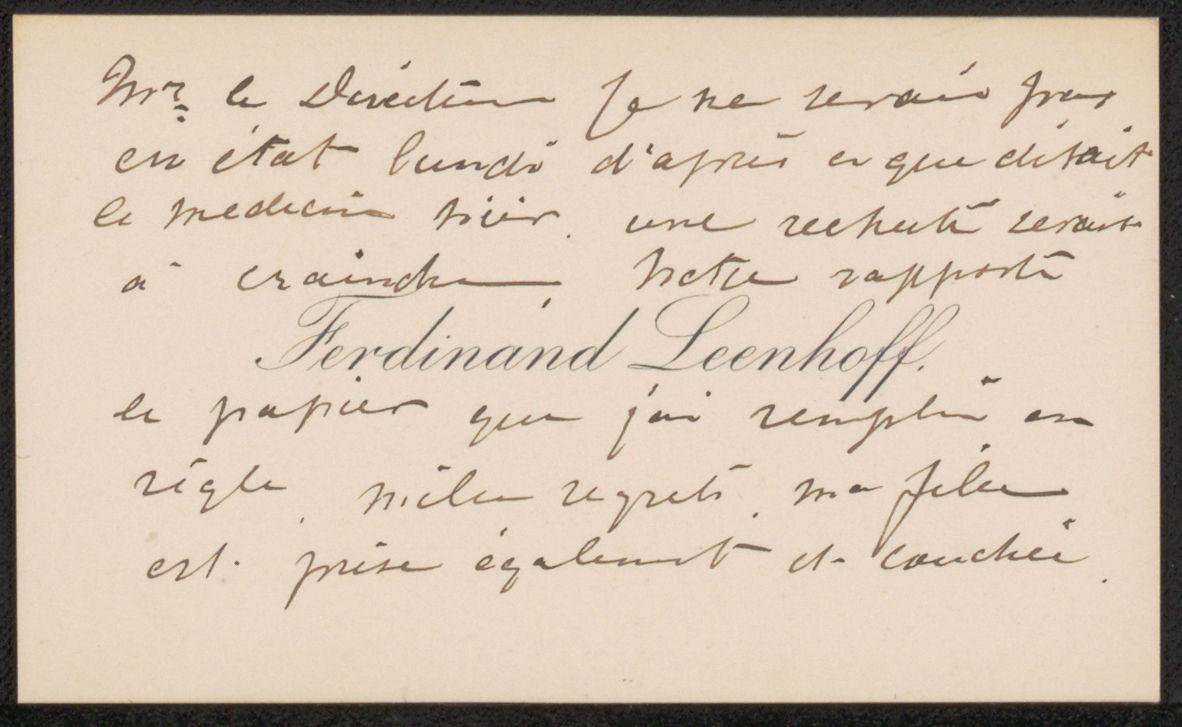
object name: visiting card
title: Visitekaartje aan August Allebé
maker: ferdinand leenhoff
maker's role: print maker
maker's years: 1841-1914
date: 1851-1914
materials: cardboard, ink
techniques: pen, printing, writing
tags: amsterdam, draughtsman, august allebé, diseases